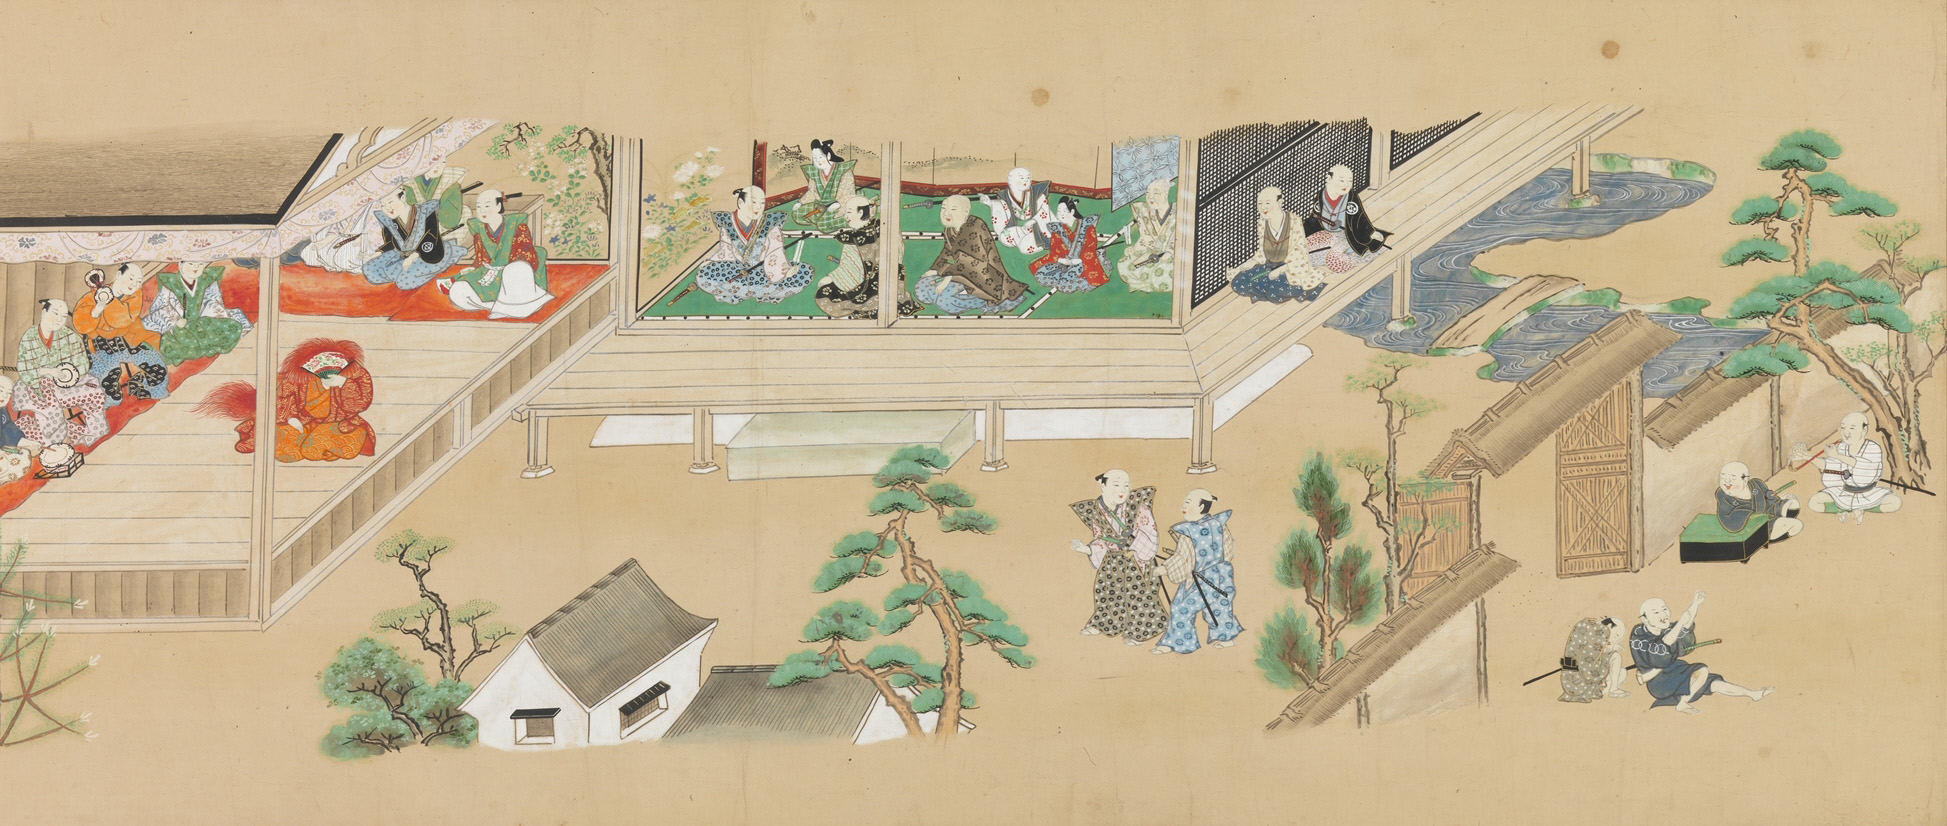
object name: handscroll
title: Six Noh Performances in Scenes from Daily Life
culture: japanese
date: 1667-1733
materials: gold, ink, paper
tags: performance,men,women,spectators